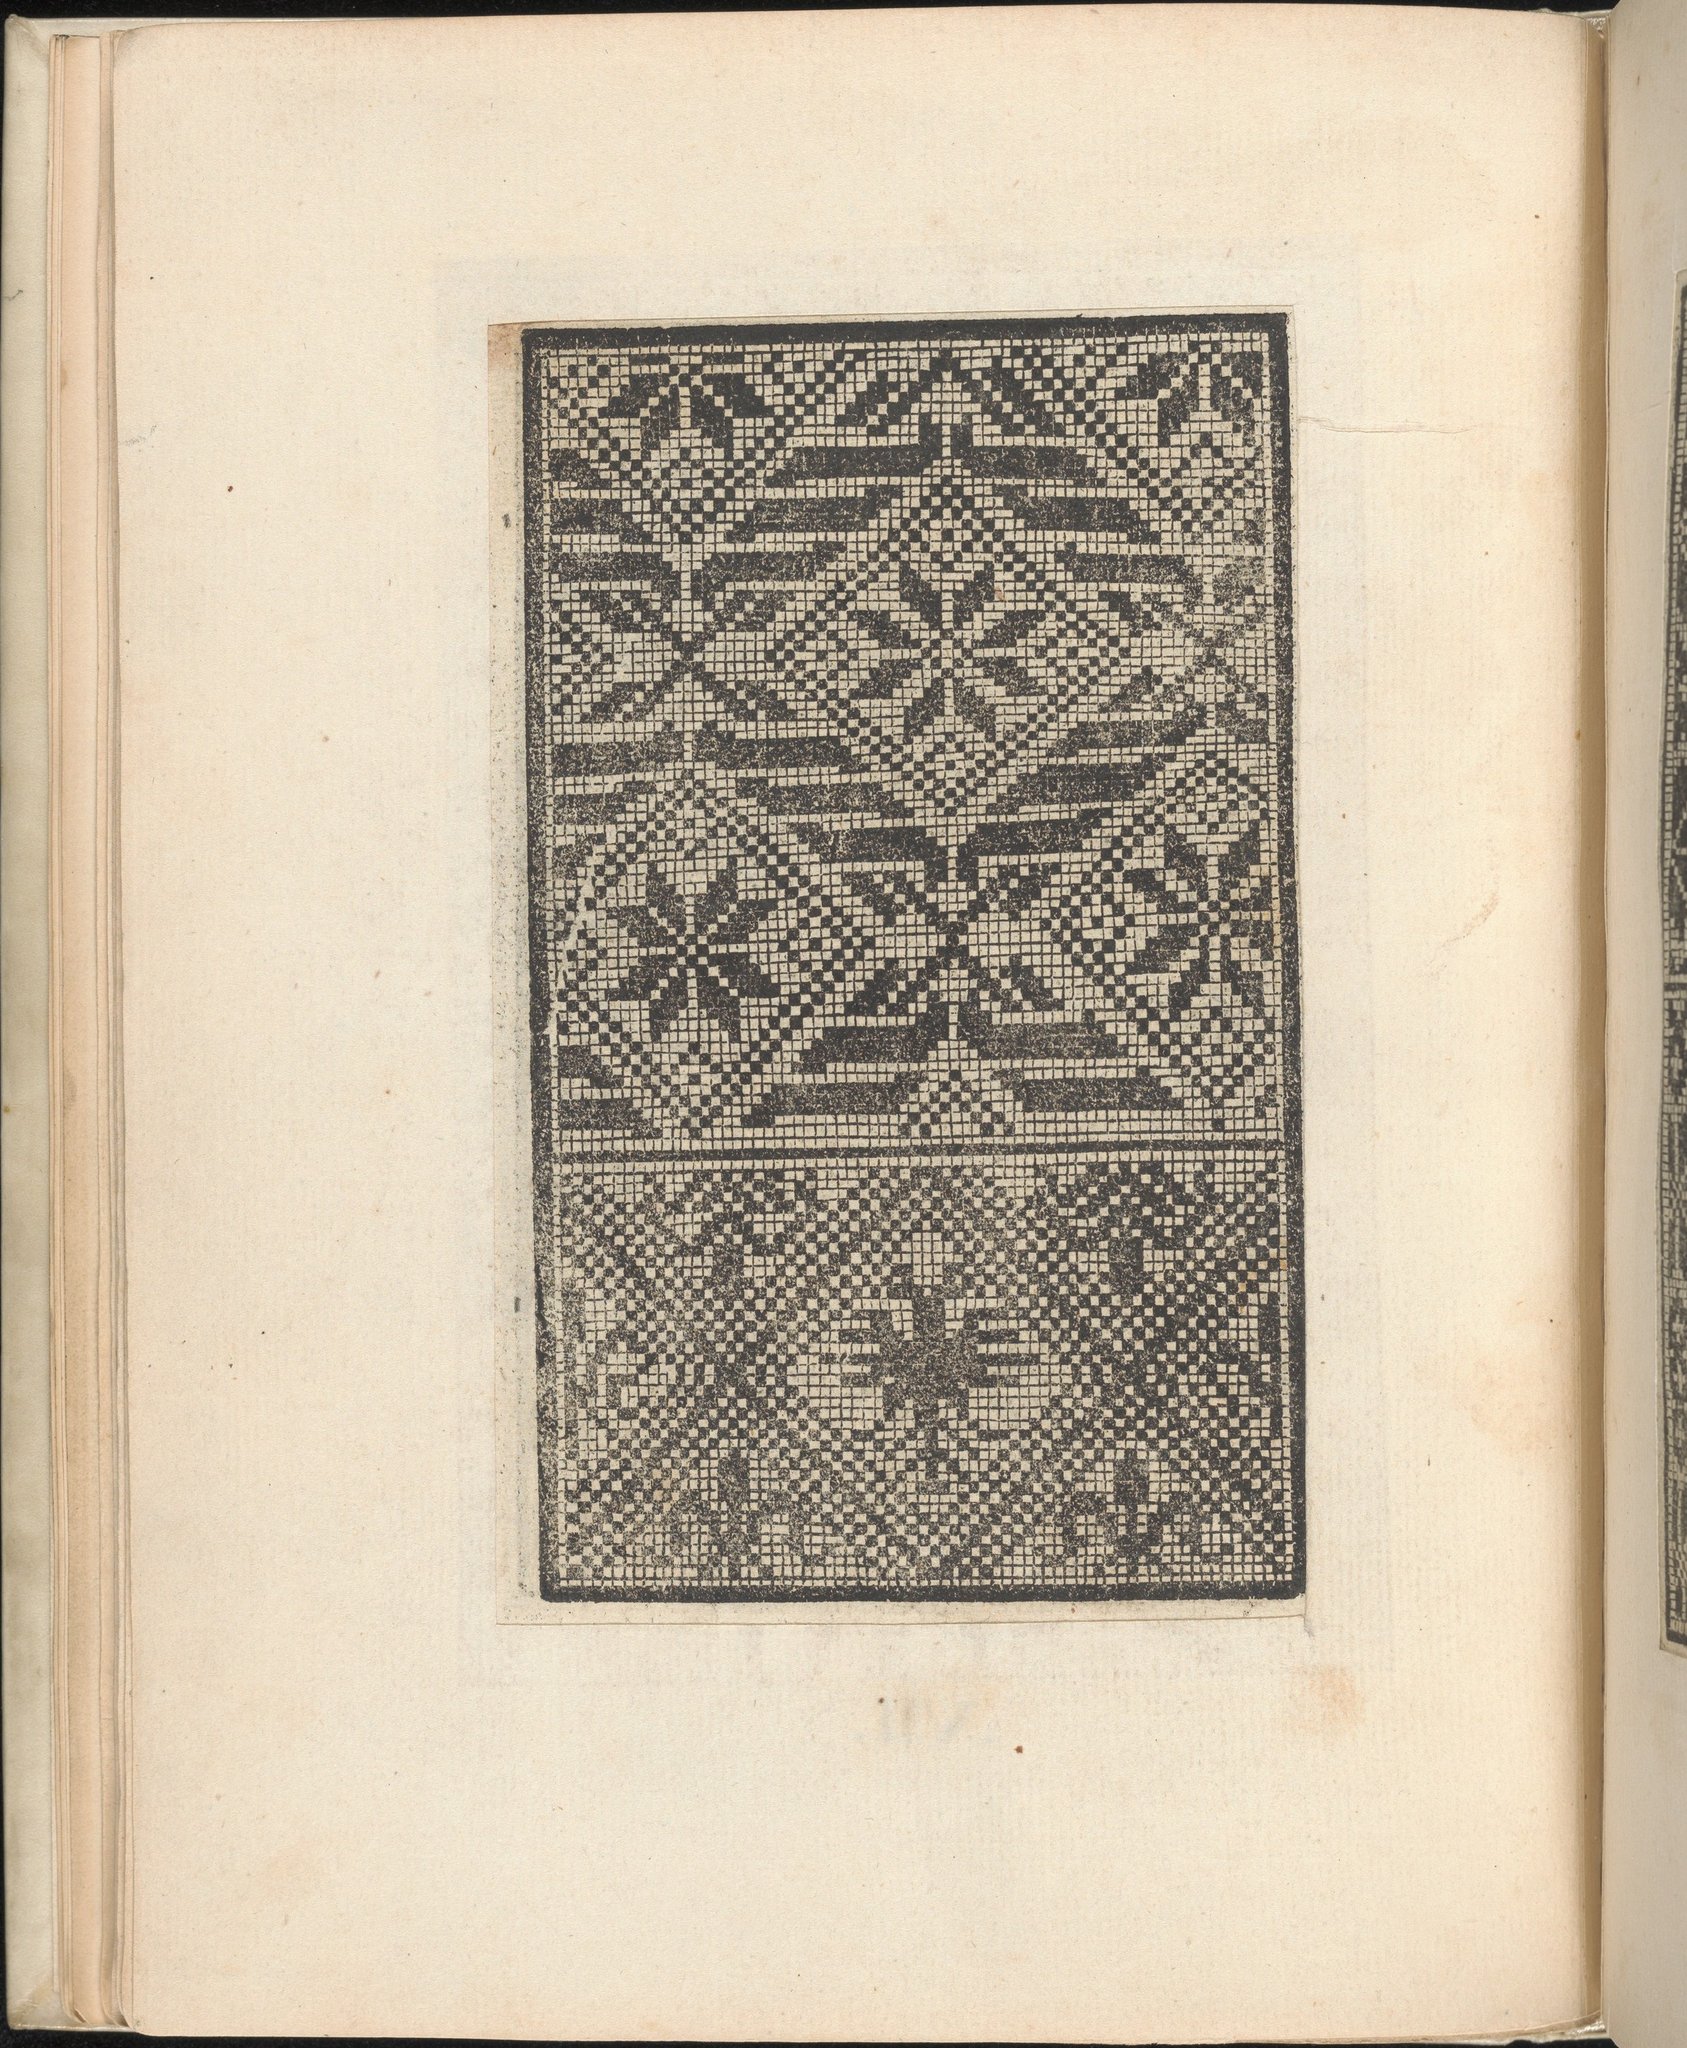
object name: book print ornament architecture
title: Esemplario di lavori, page 7 (verso)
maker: nicolò zoppino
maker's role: publisher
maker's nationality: italian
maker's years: 1478-1544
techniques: bookbinding, inlay, woodcut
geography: italy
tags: ornament